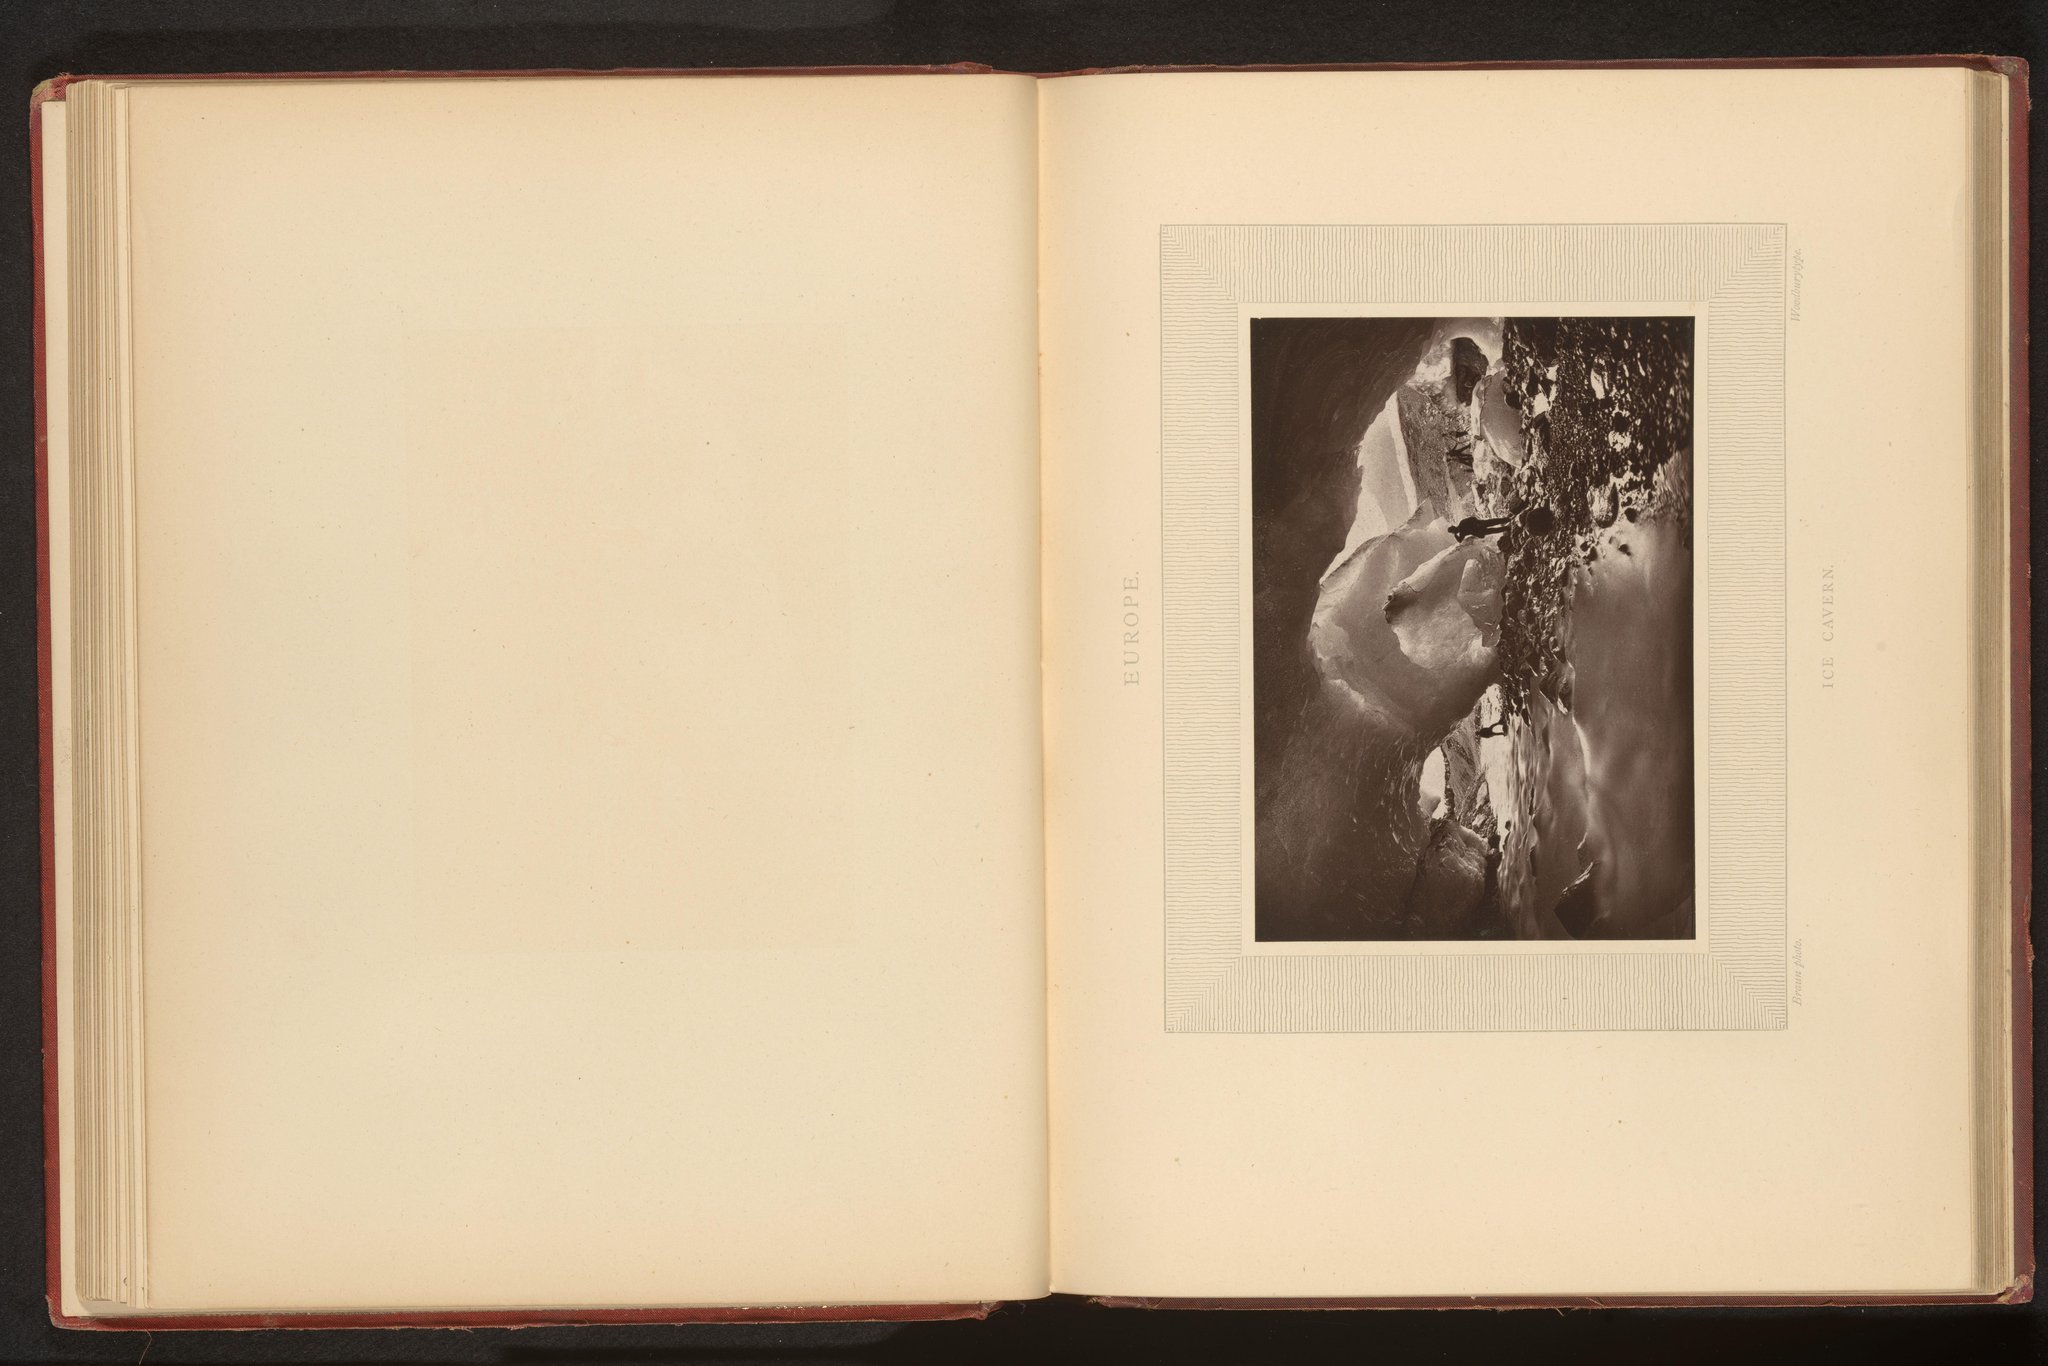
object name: page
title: IJsgrot in de Alpen met bezoekers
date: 1870-1875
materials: cardboard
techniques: woodburytype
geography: gizeh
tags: ice ~ state of water, cave, grotto (+ landscape with figures, staffage)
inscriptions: inscription: ‘Europe’, inscription: ‘Braun photo.’